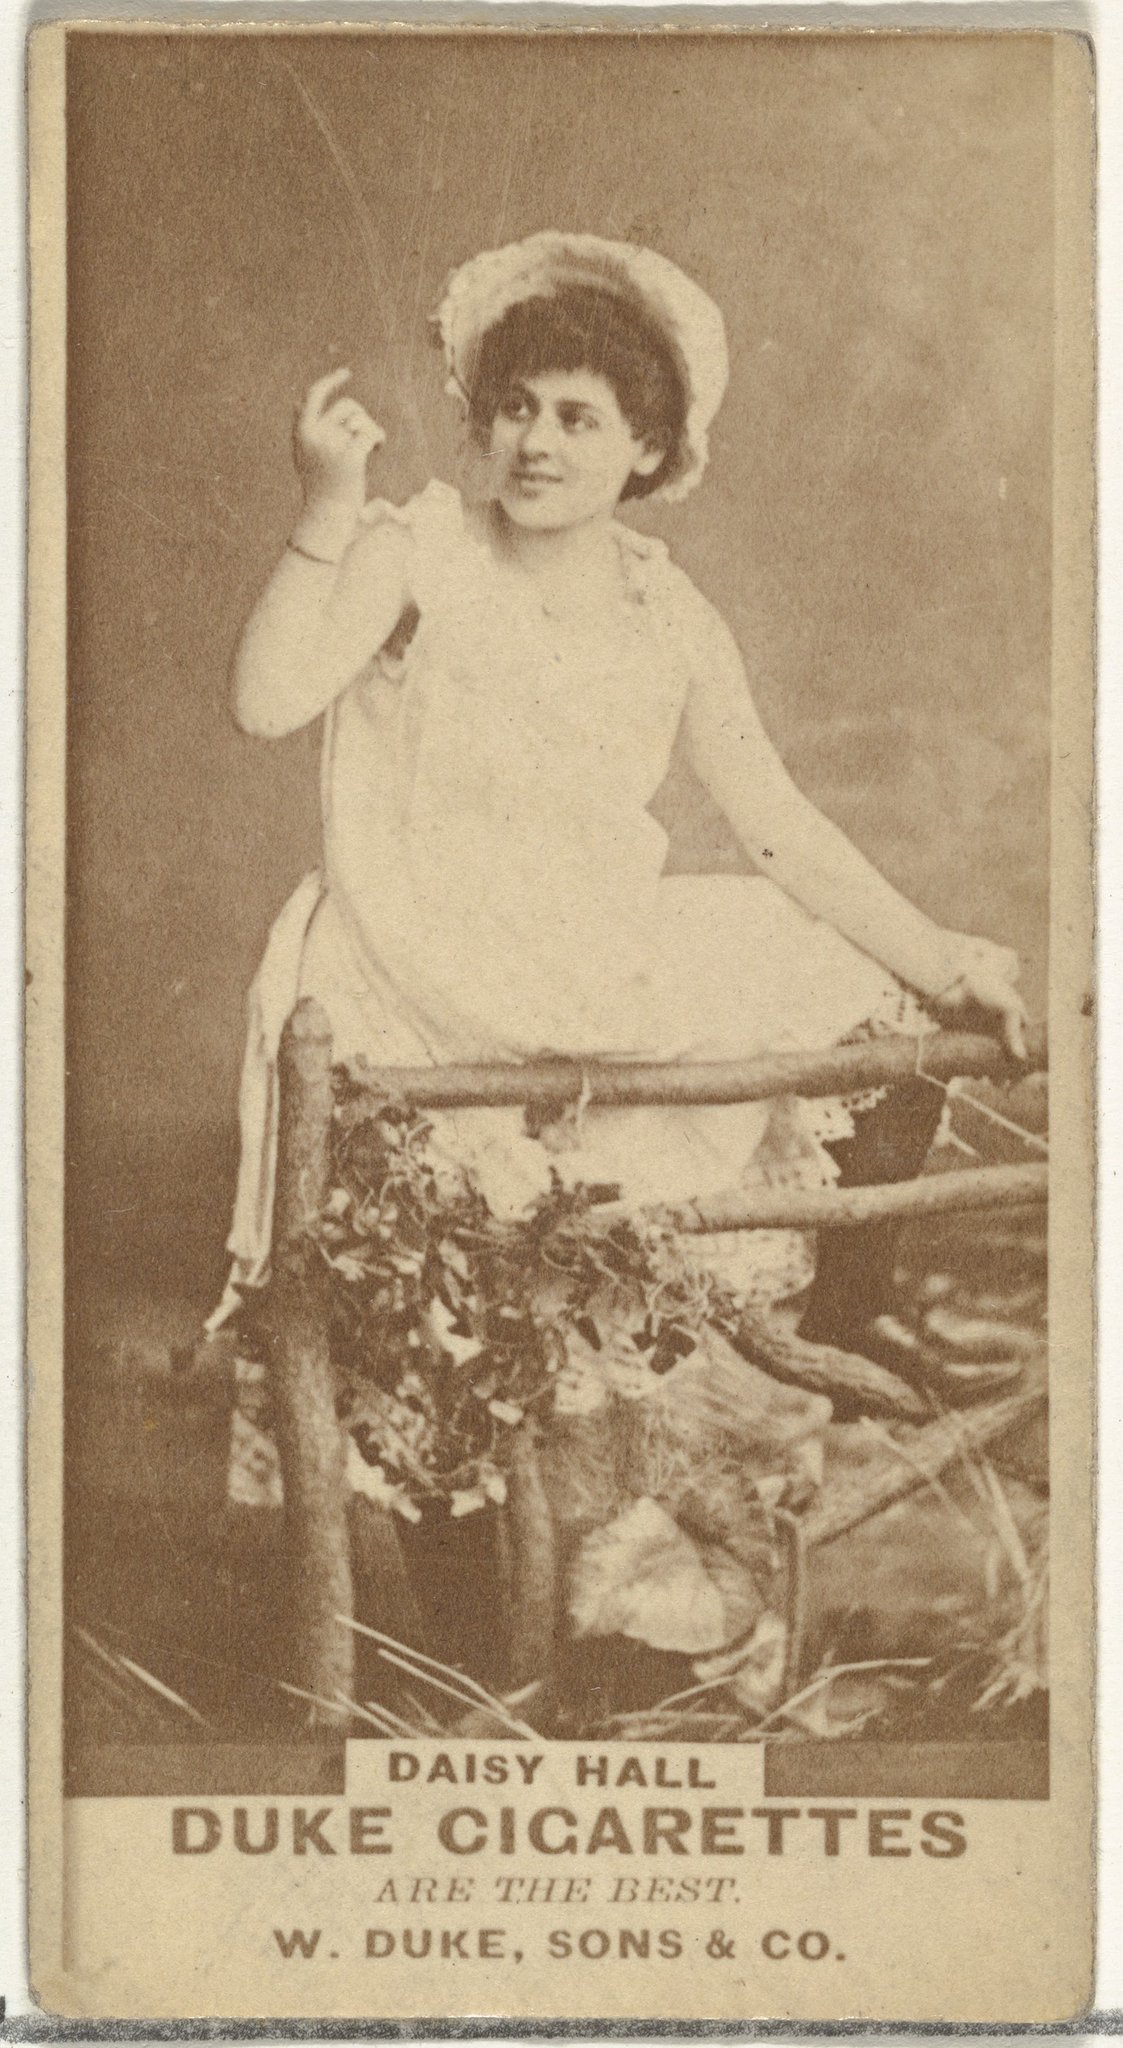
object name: photograph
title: Daisy Hall, from the Actors and Actresses series (N145-7) issued by Duke Sons & Co. to promote Duke Cigarettes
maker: w. duke, sons & co.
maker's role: publisher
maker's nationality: american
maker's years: 1870-1920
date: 1880-1889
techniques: albumen silver print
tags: portraits,women,actresses